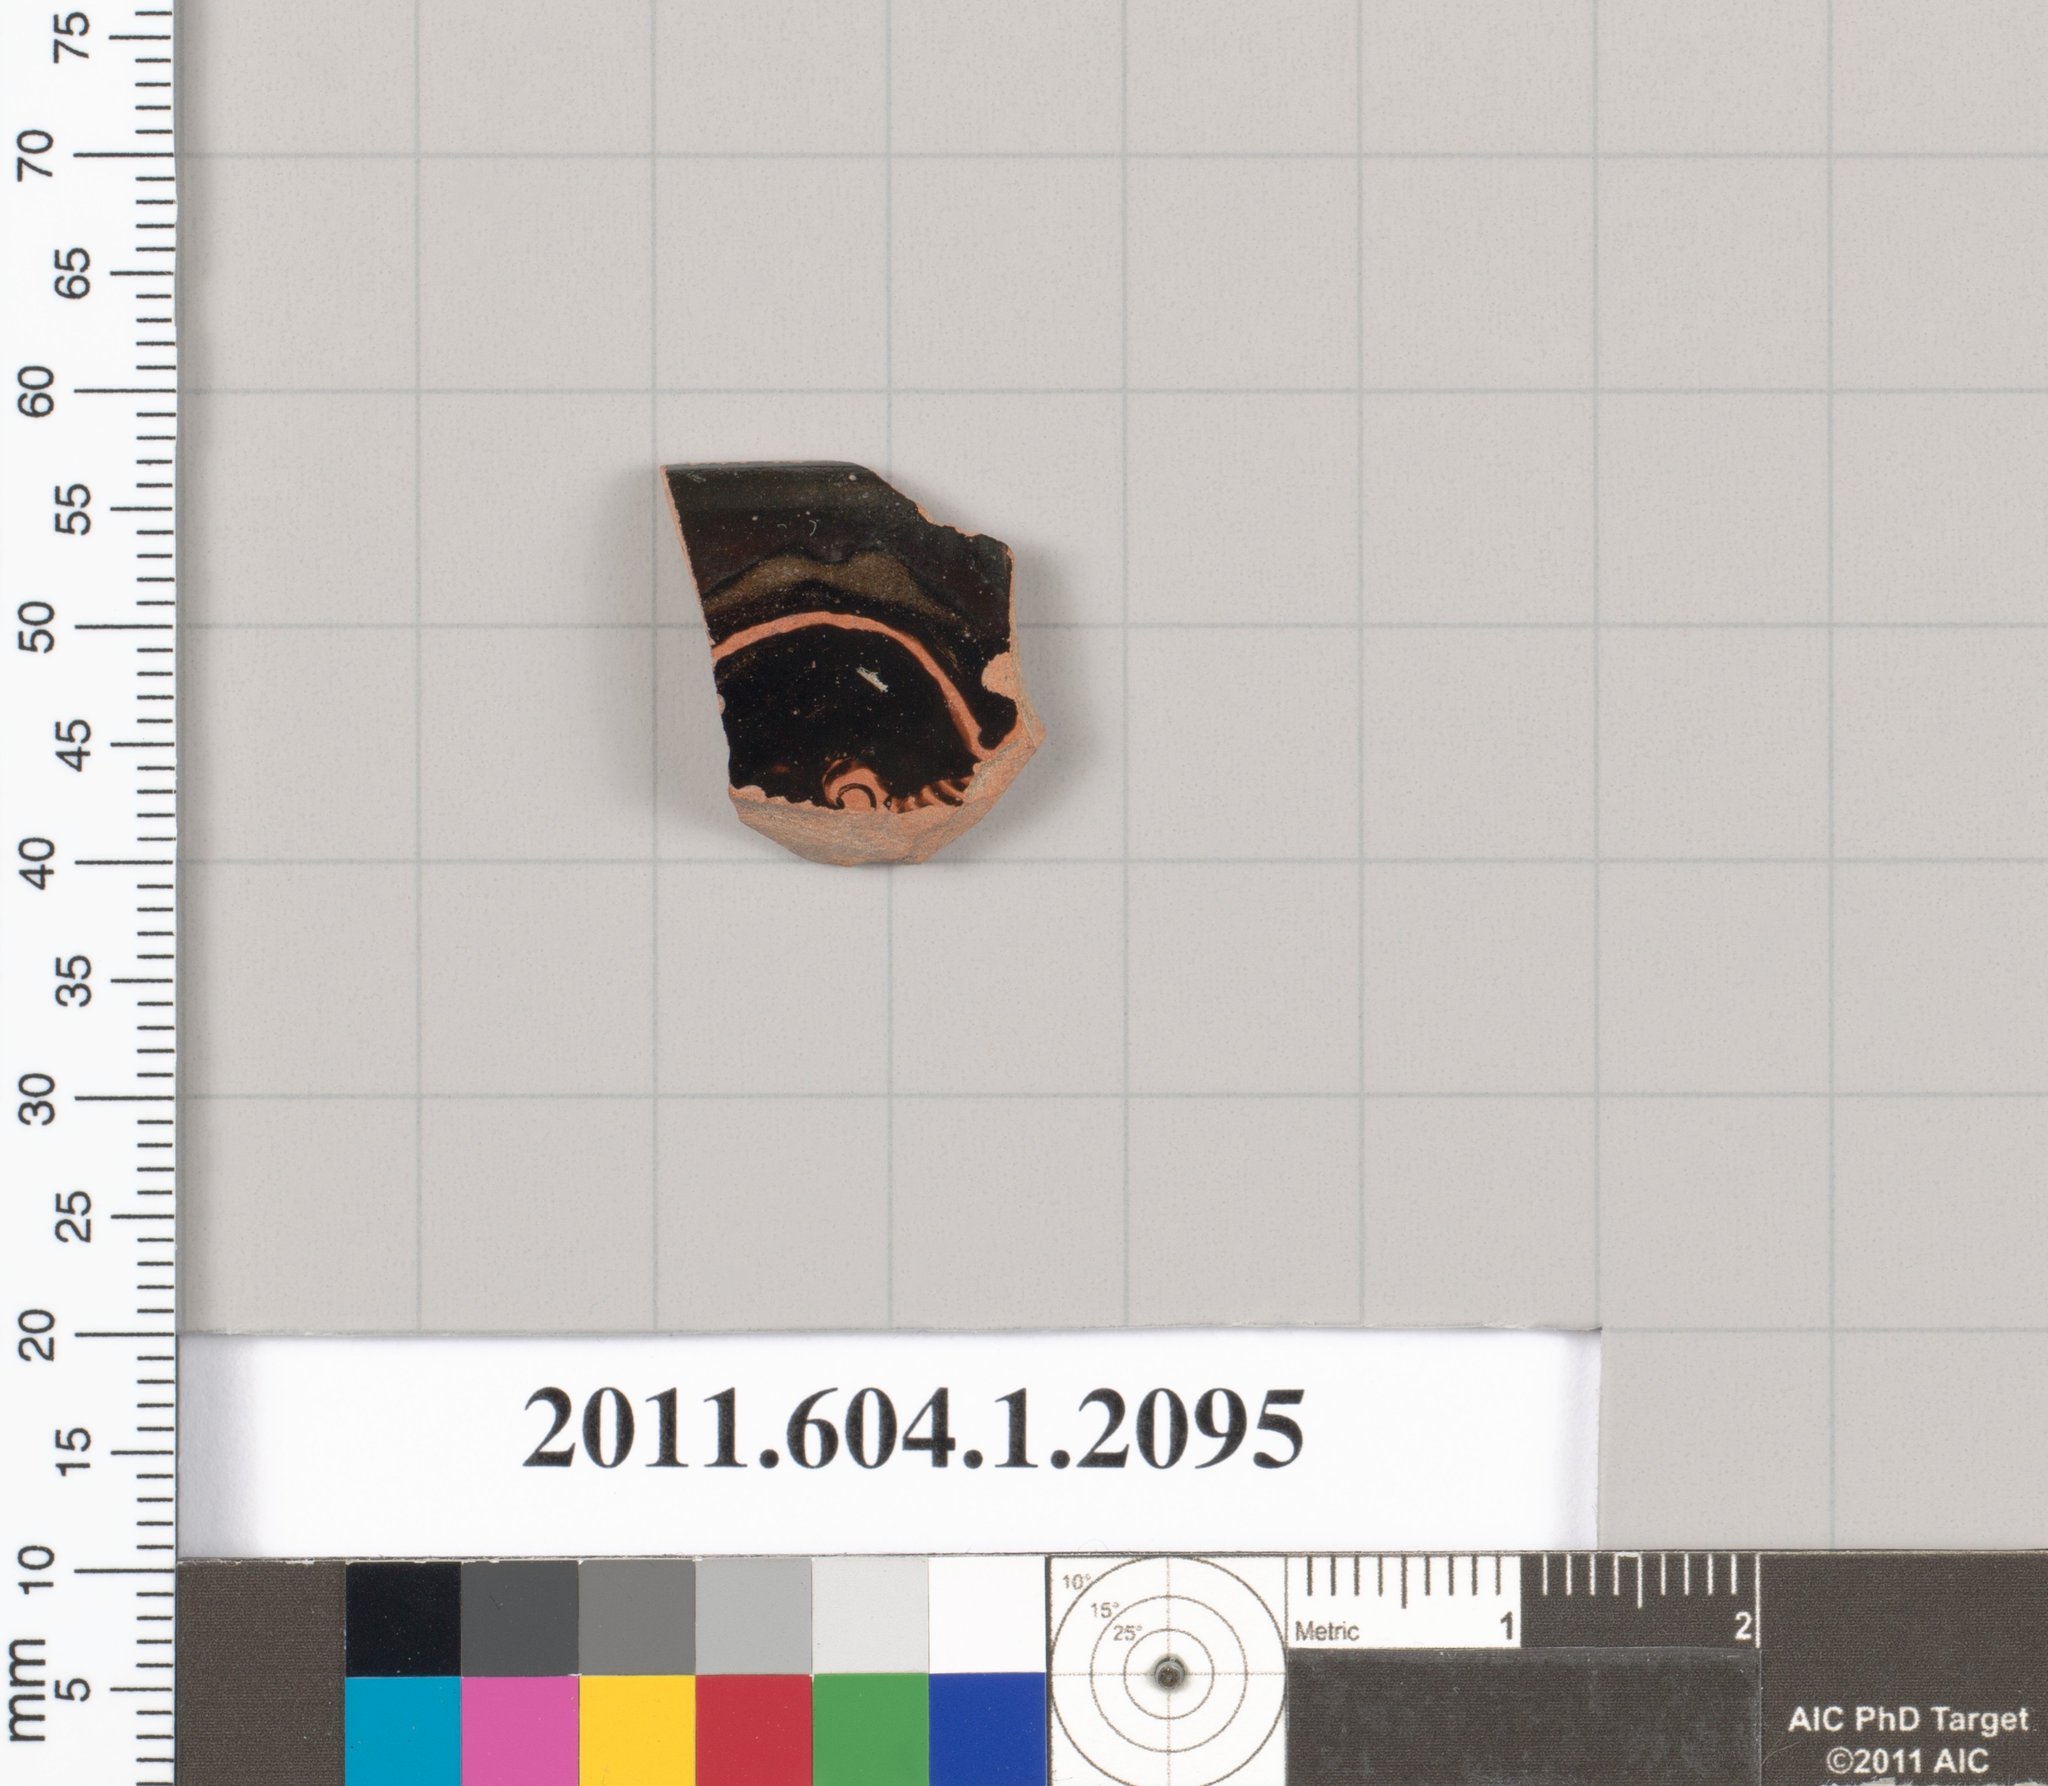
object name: kylix fragment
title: Terracotta rim fragment of a kylix (drinking cup)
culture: greek, attic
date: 475-451 BCE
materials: terracotta